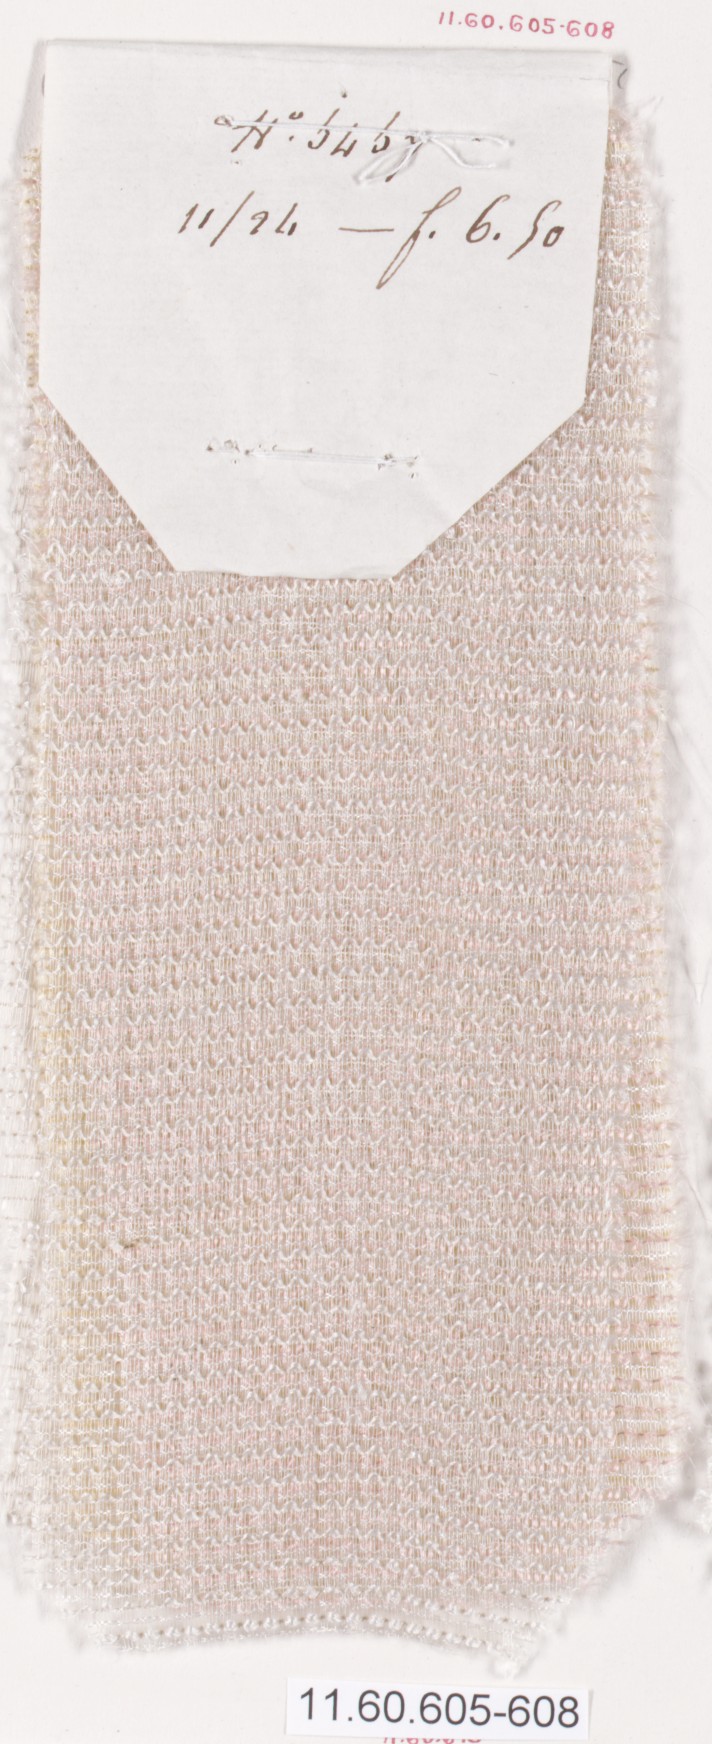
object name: sample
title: Samples (4)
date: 1801-1833